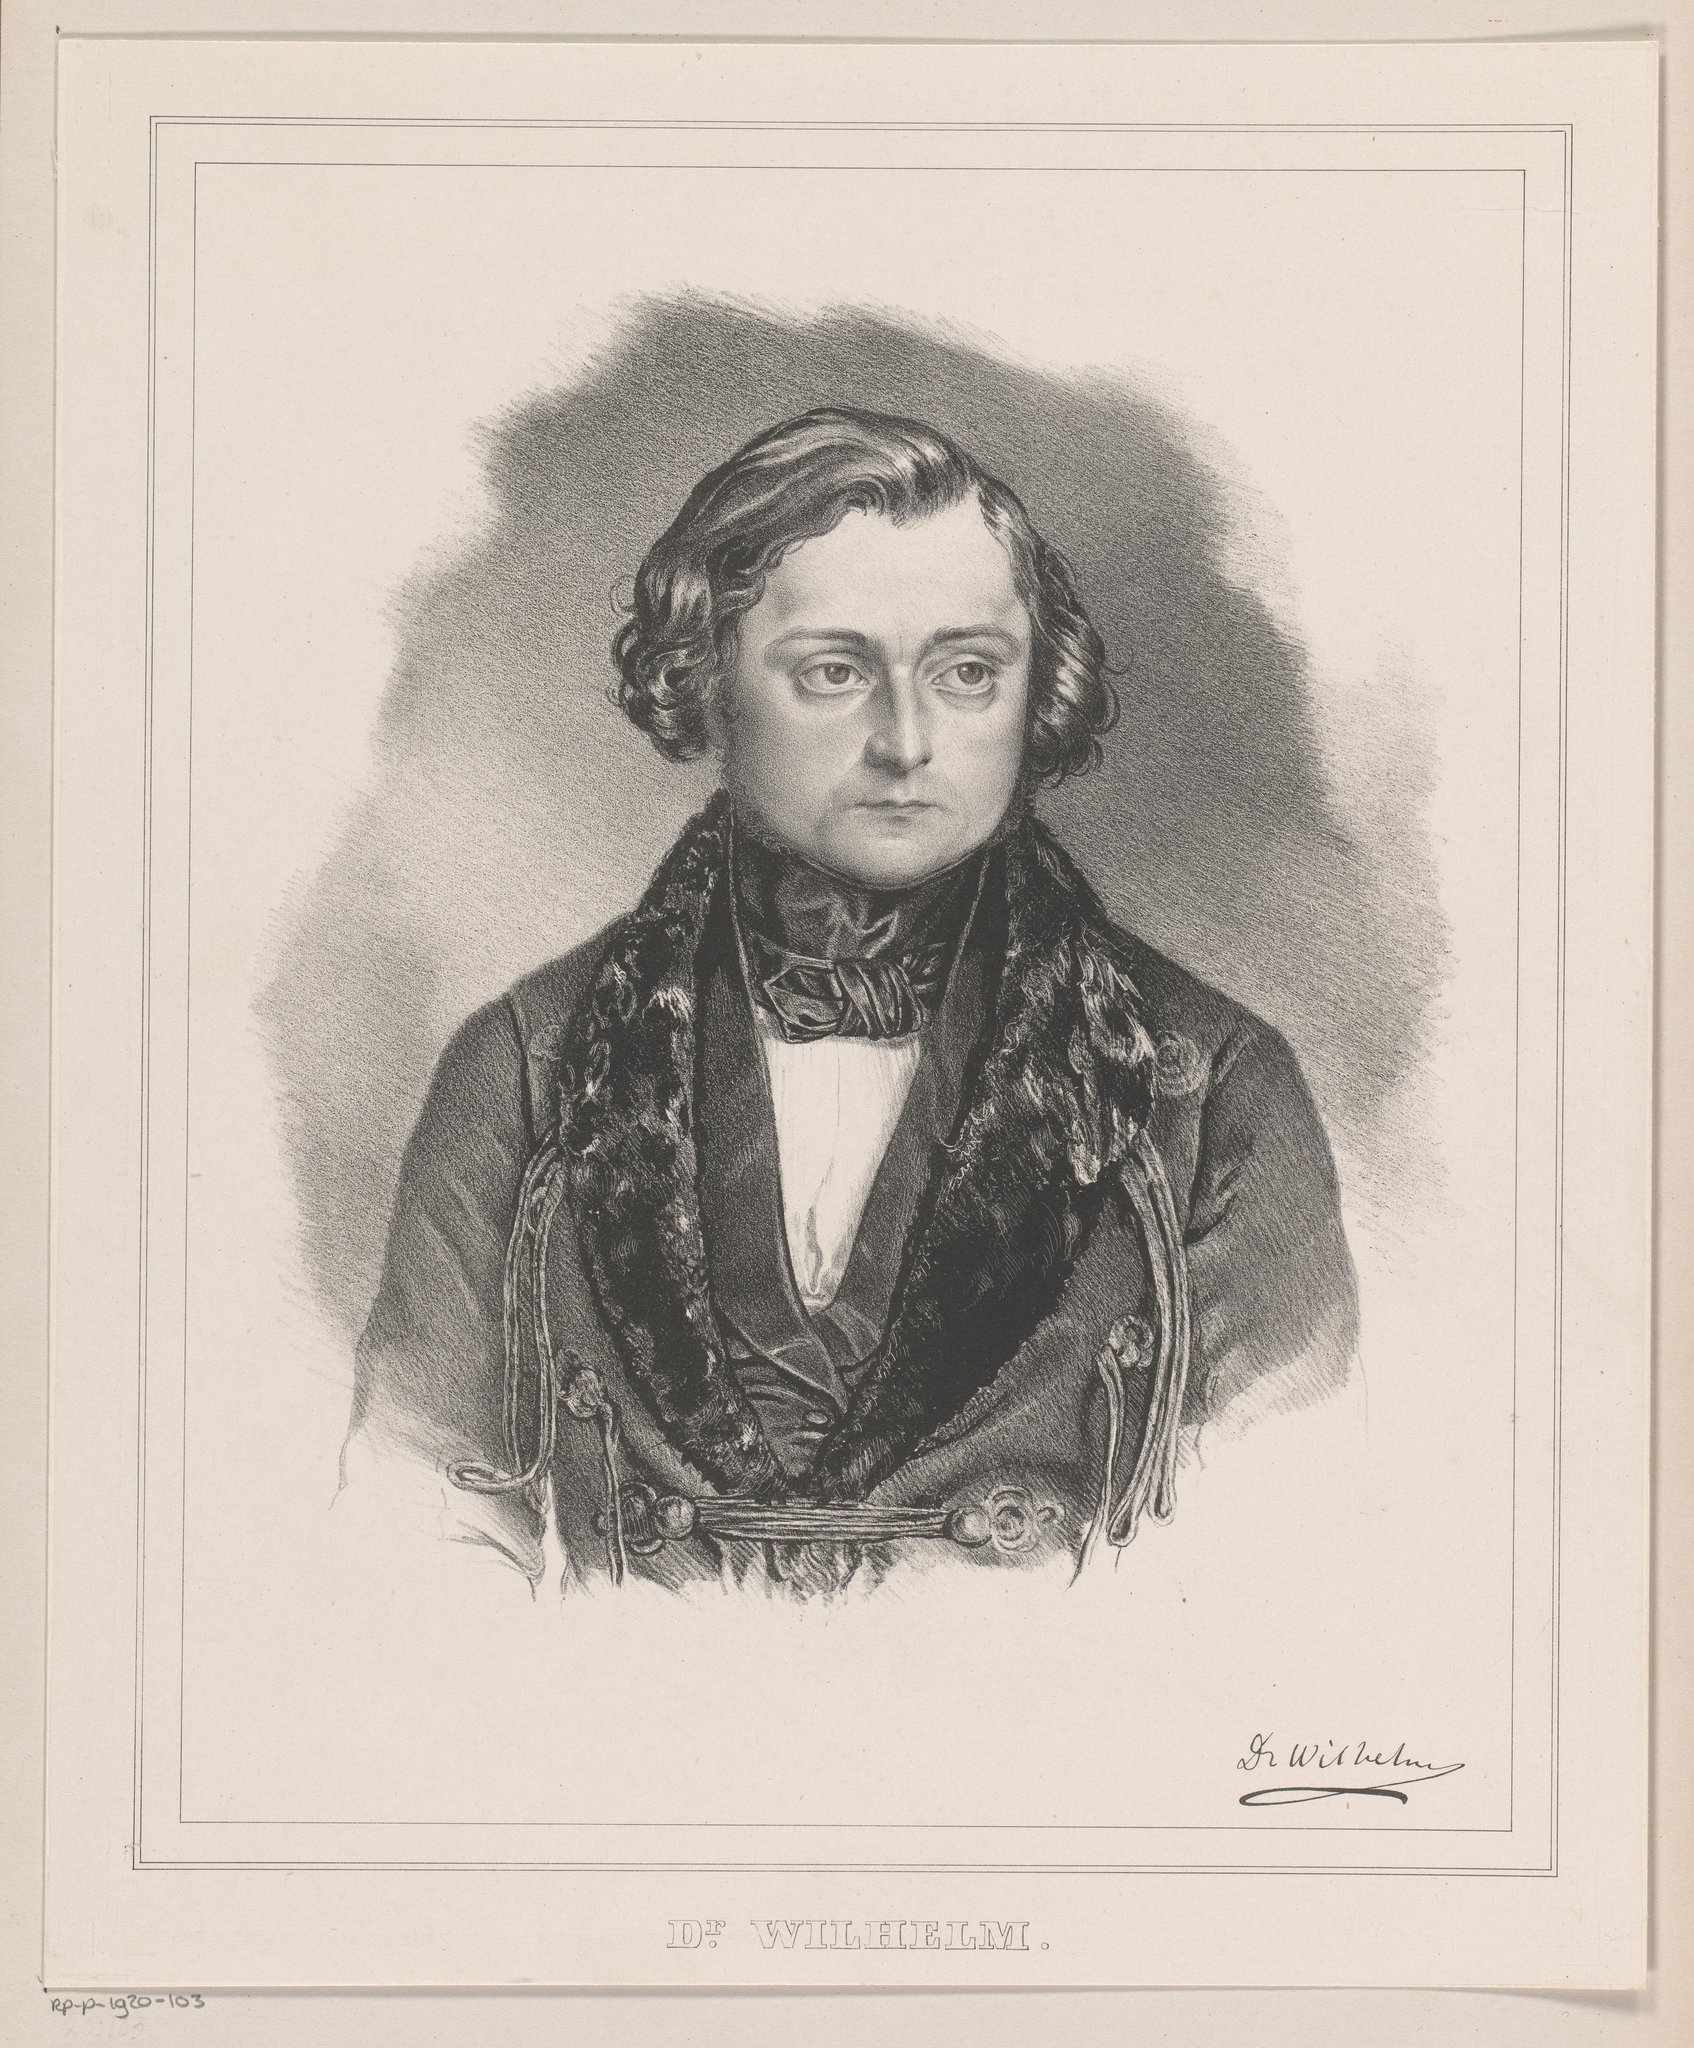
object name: print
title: Portret van Philipp Wilhelm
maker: Anonymous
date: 1828-1840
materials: paper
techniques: lithograph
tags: historical persons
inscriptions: collector's mark: Lugt 2228